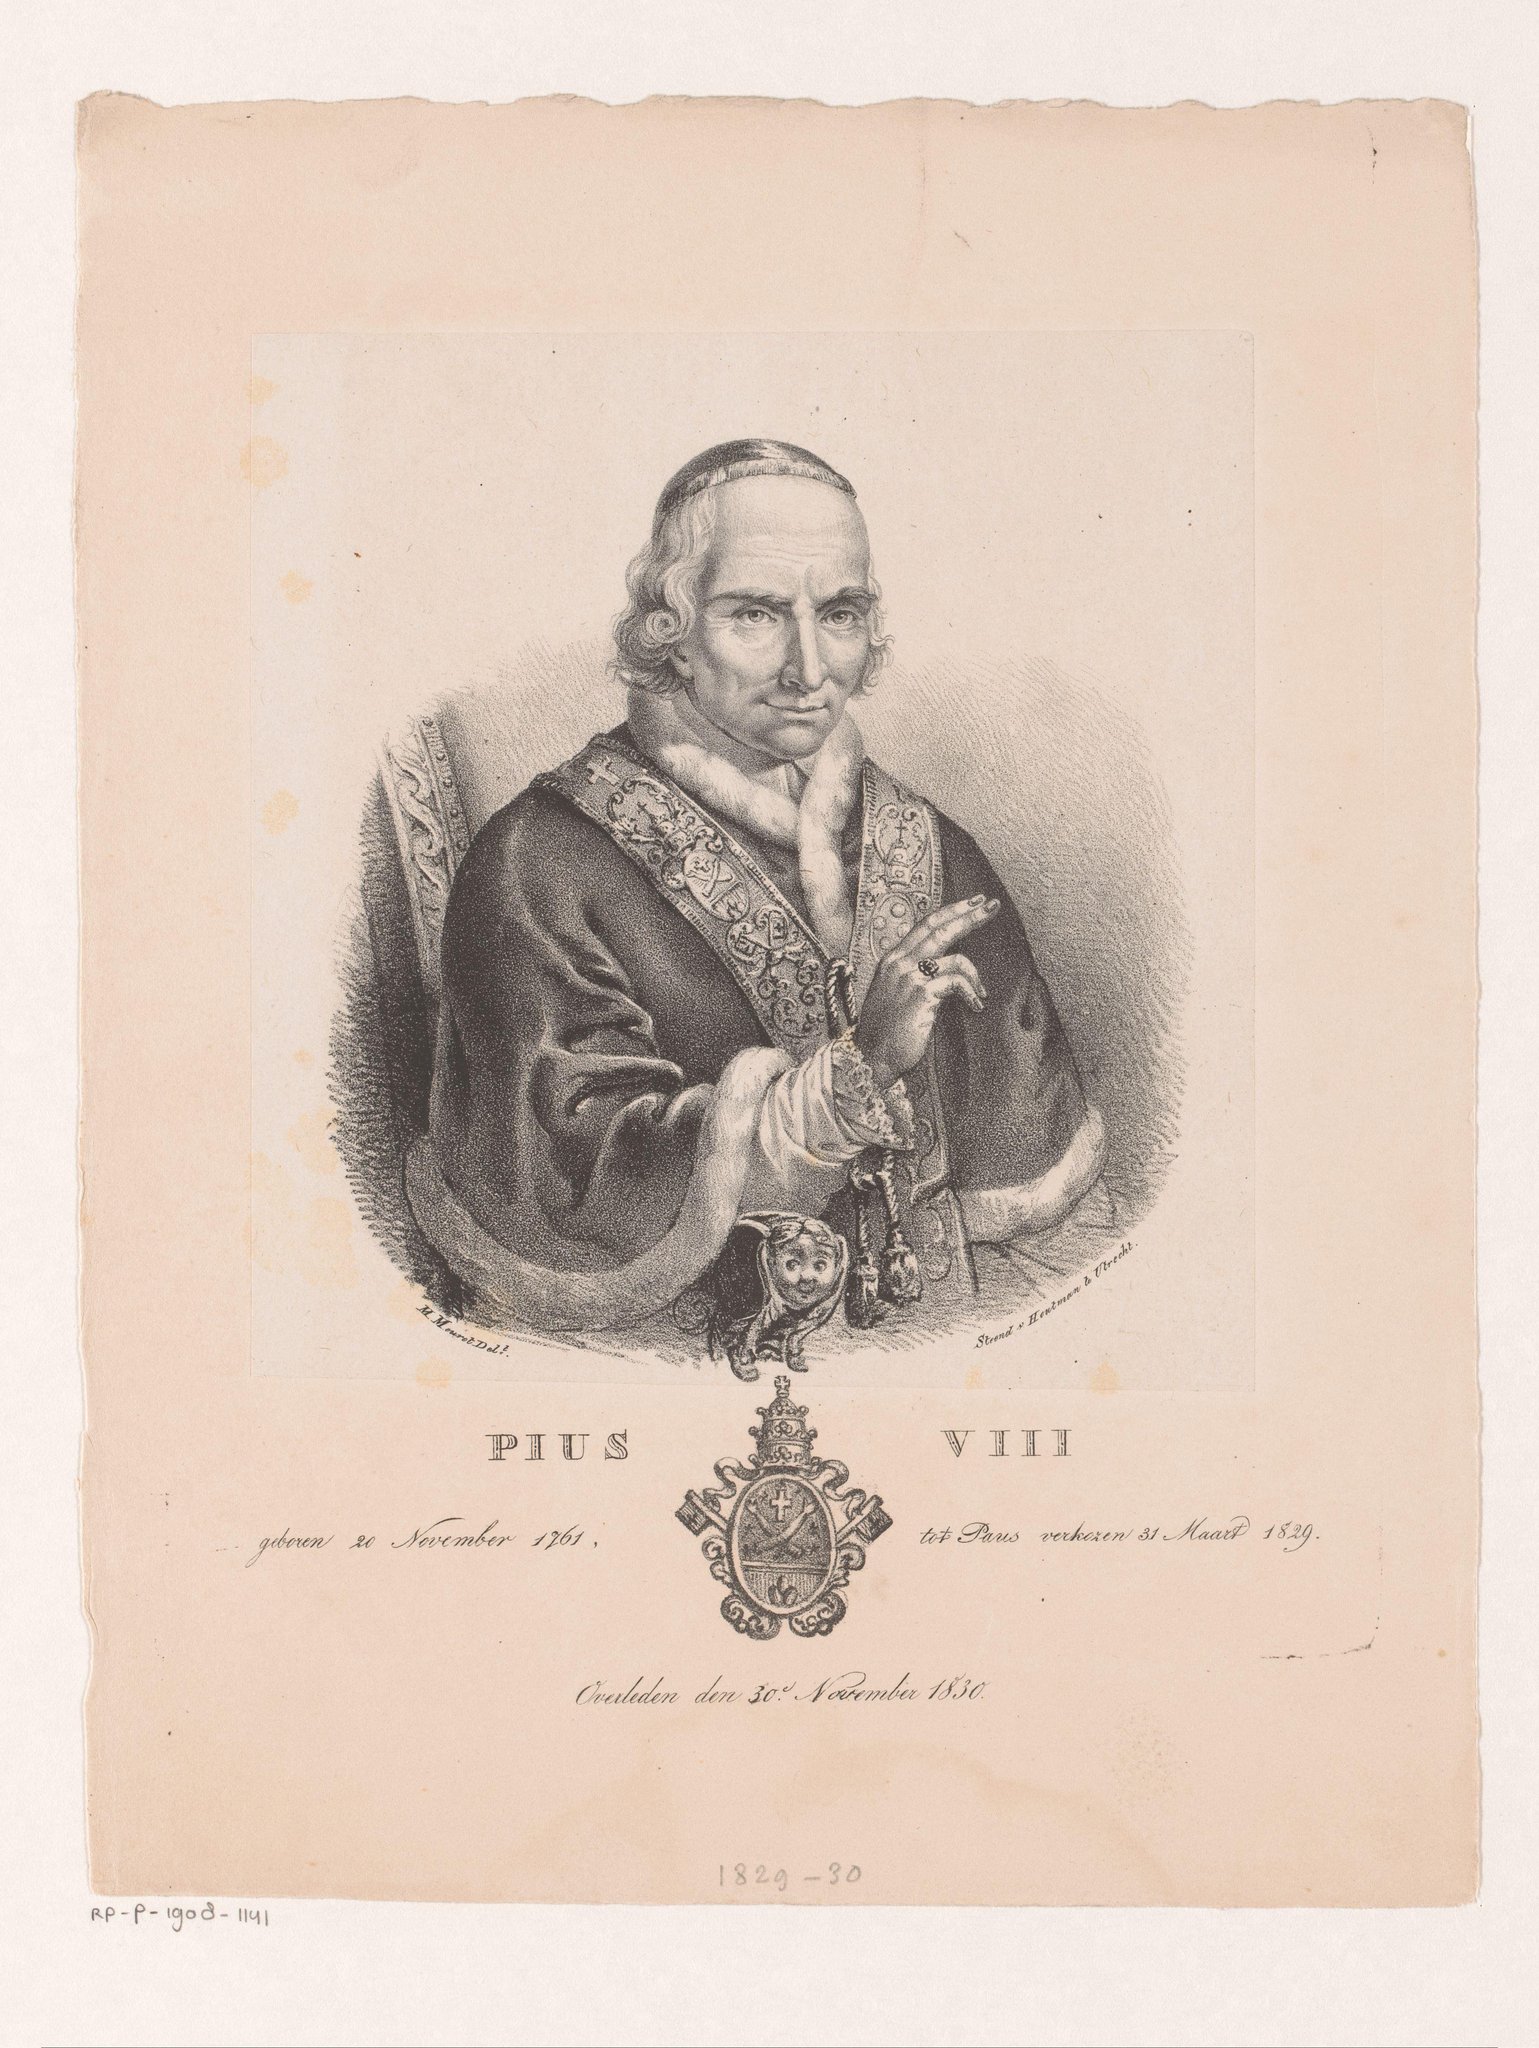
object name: print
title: Portret van paus Pius VIII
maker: johannes paulus houtman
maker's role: bookseller, print maker, printer, publisher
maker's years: 1803-1845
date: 1830-1843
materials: paper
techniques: lithograph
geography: utrecht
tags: rome, index finger and middle finger raised, closed, historical persons (+ (full) bust portrait)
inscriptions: collector's mark: Lugt 2228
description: De paus maakt met zijn rechterhand het spreekgebaar.